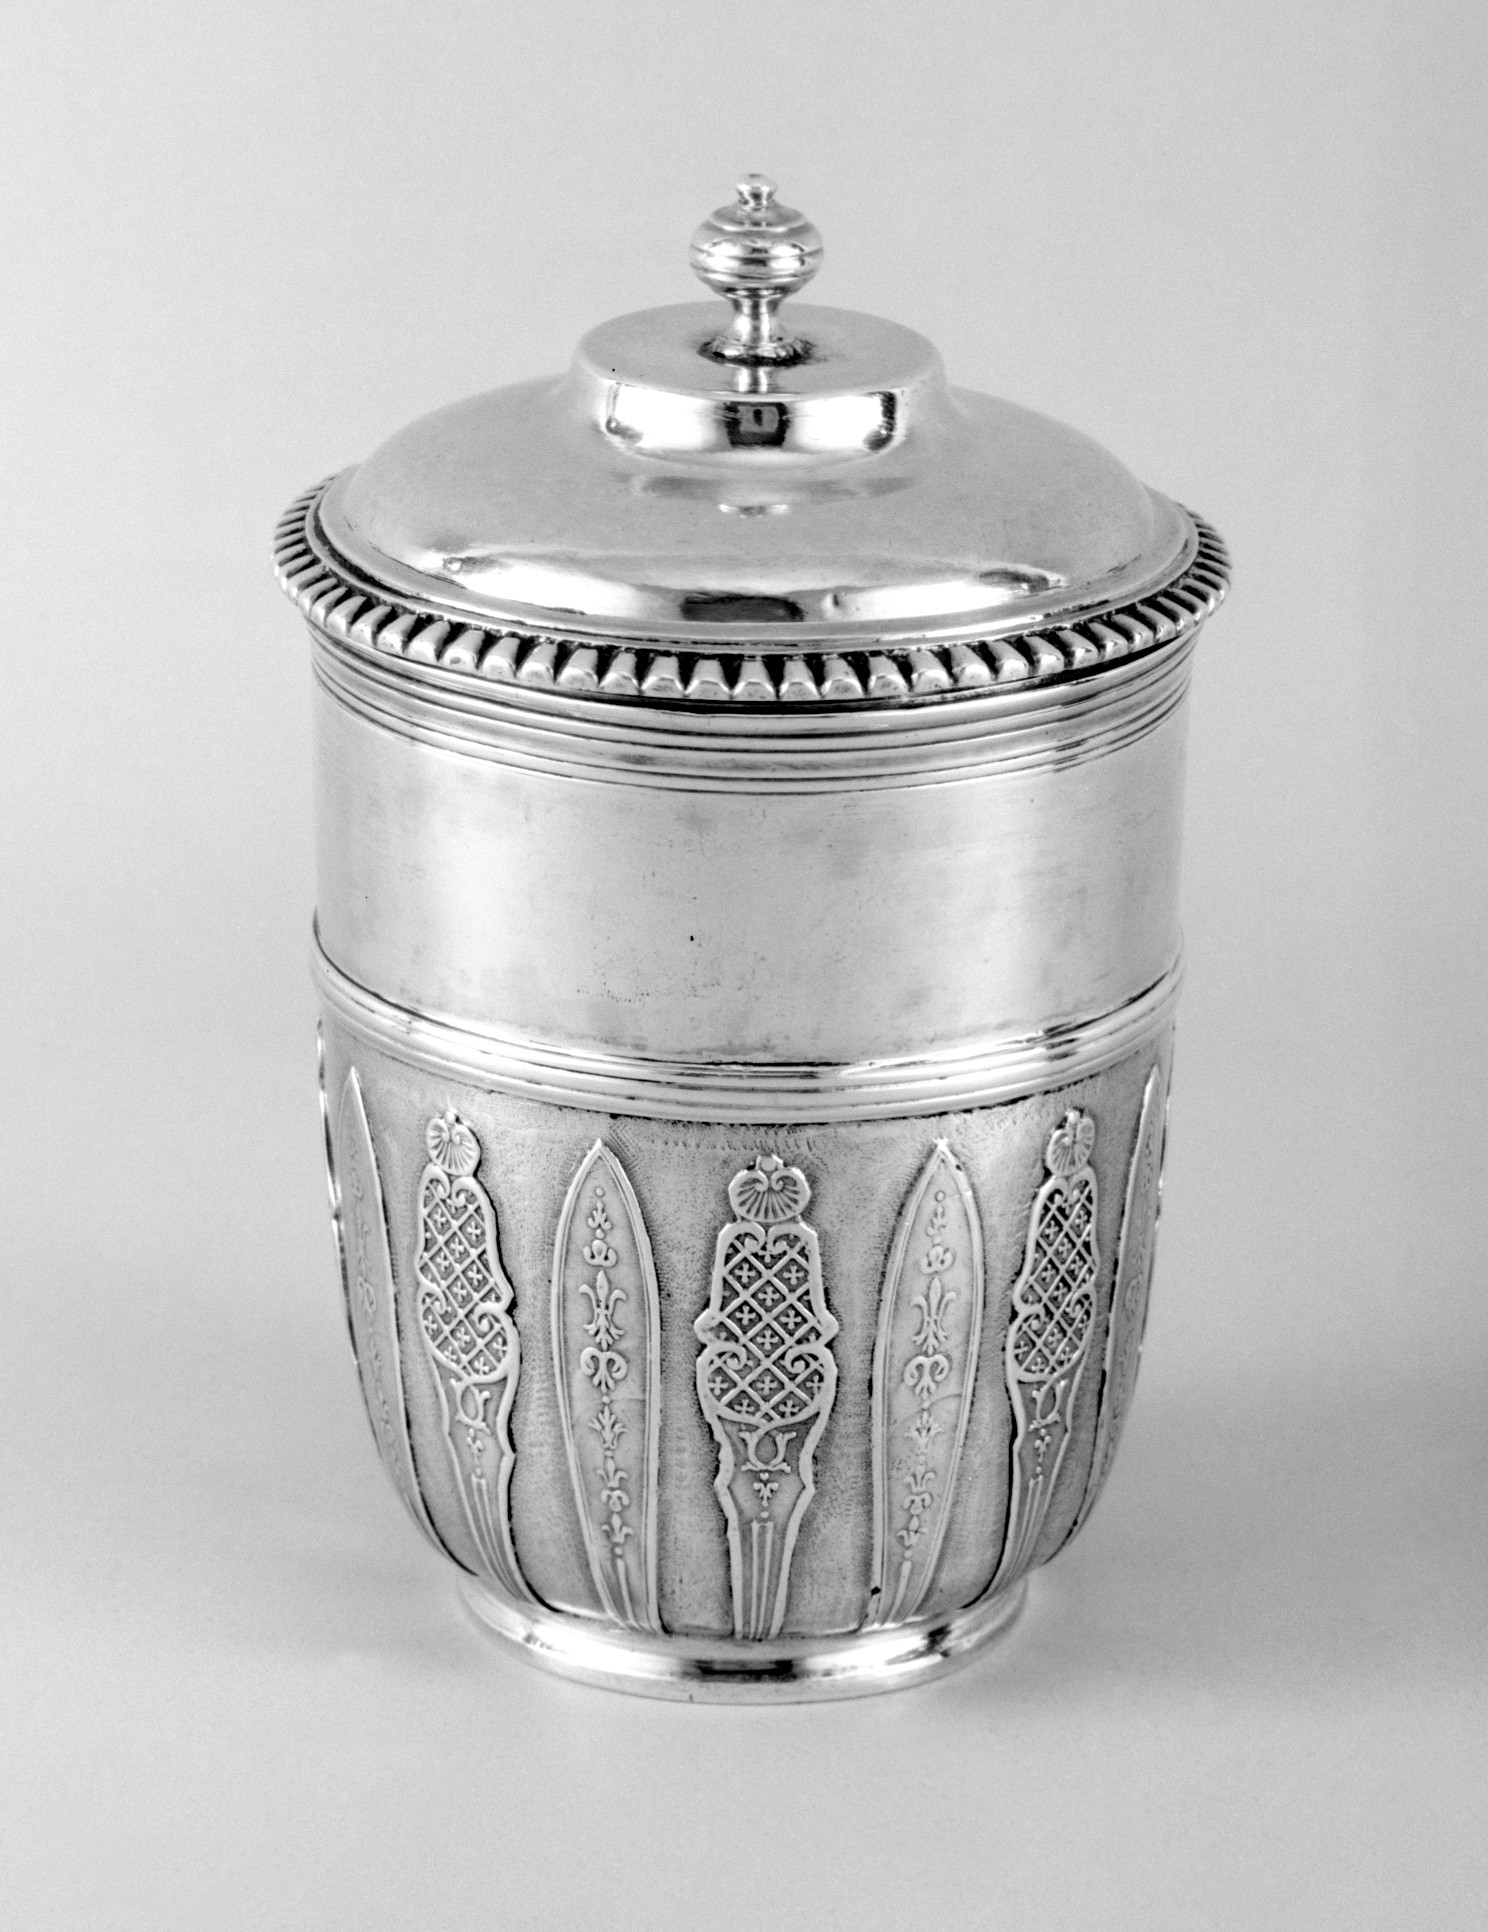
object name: jar with cover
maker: v.c.d.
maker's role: maker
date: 1740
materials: silver